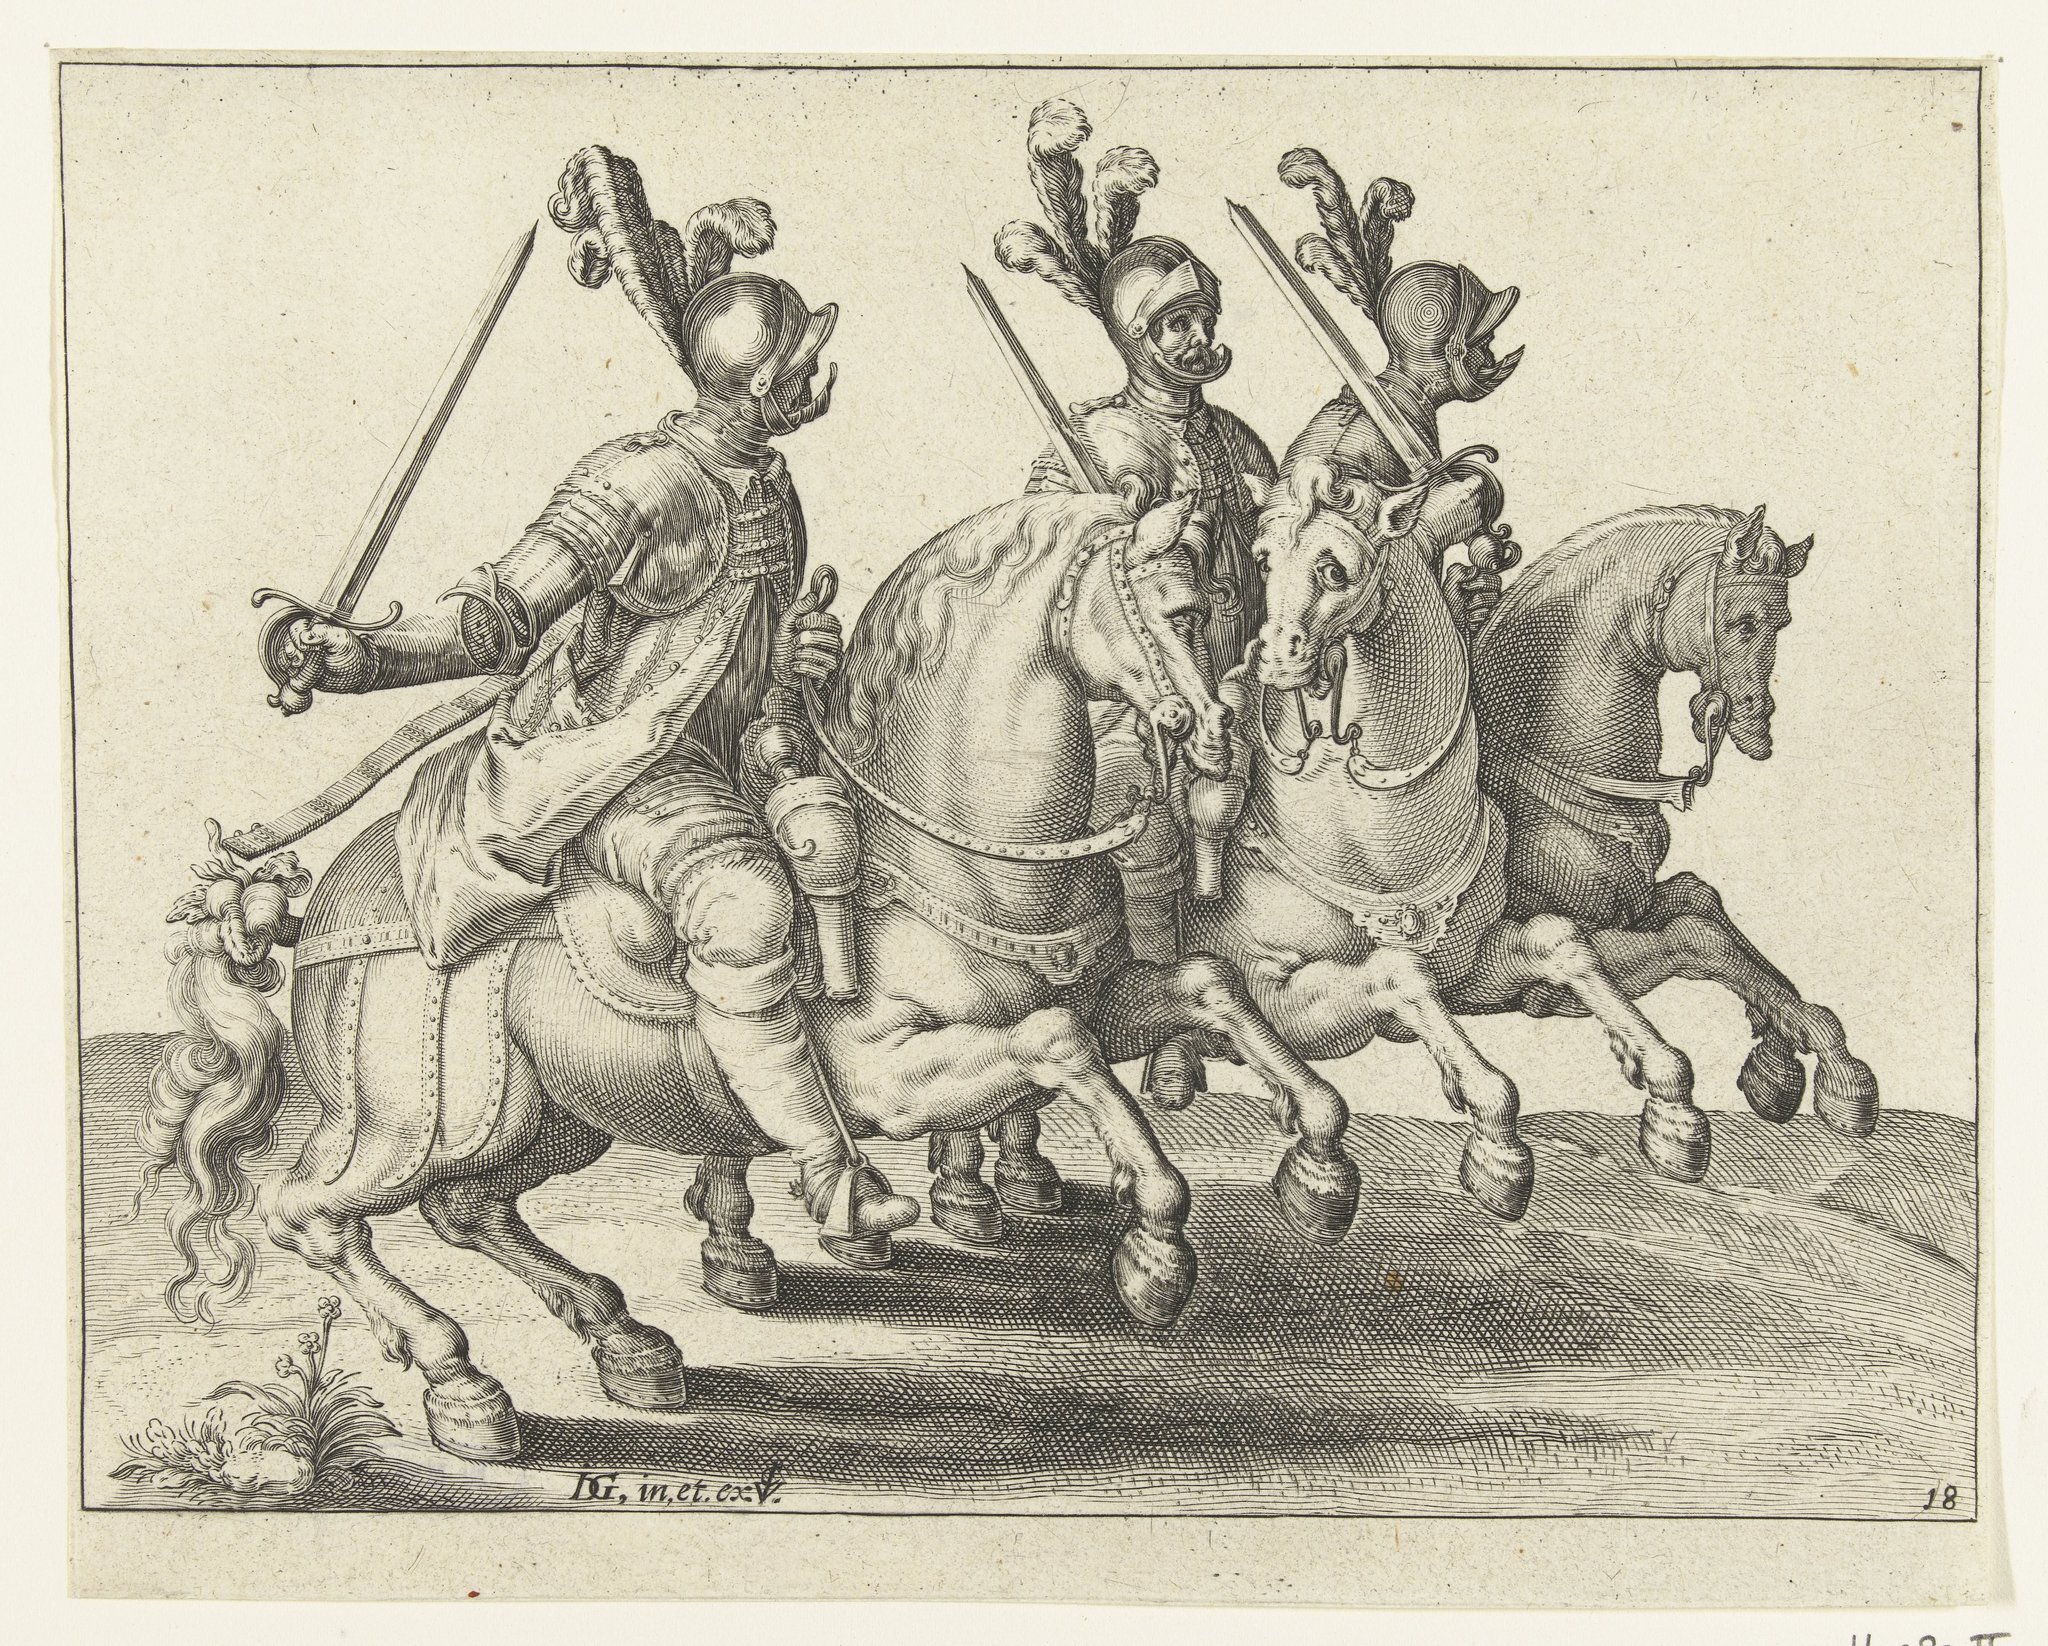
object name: print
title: De ruiterschool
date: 1599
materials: paper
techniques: engraving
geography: amsterdam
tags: hacking and thrusting weapons: sword, warfare; military affairs (+ cavalry, horsemen)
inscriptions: collector's mark: Lugt 2228a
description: Drie geharnaste mannen te paard, naar rechts rijdend, elk met een getrokken zwaard in de rechterhand. Deze prent is onderdeel van een serie van 22 genummerde prenten: een titelprent, 20 prenten waarop één of enkele verschillende typen (meest geharnaste) ruiters zijn weergegeven, en een prent met een ruitergevecht.